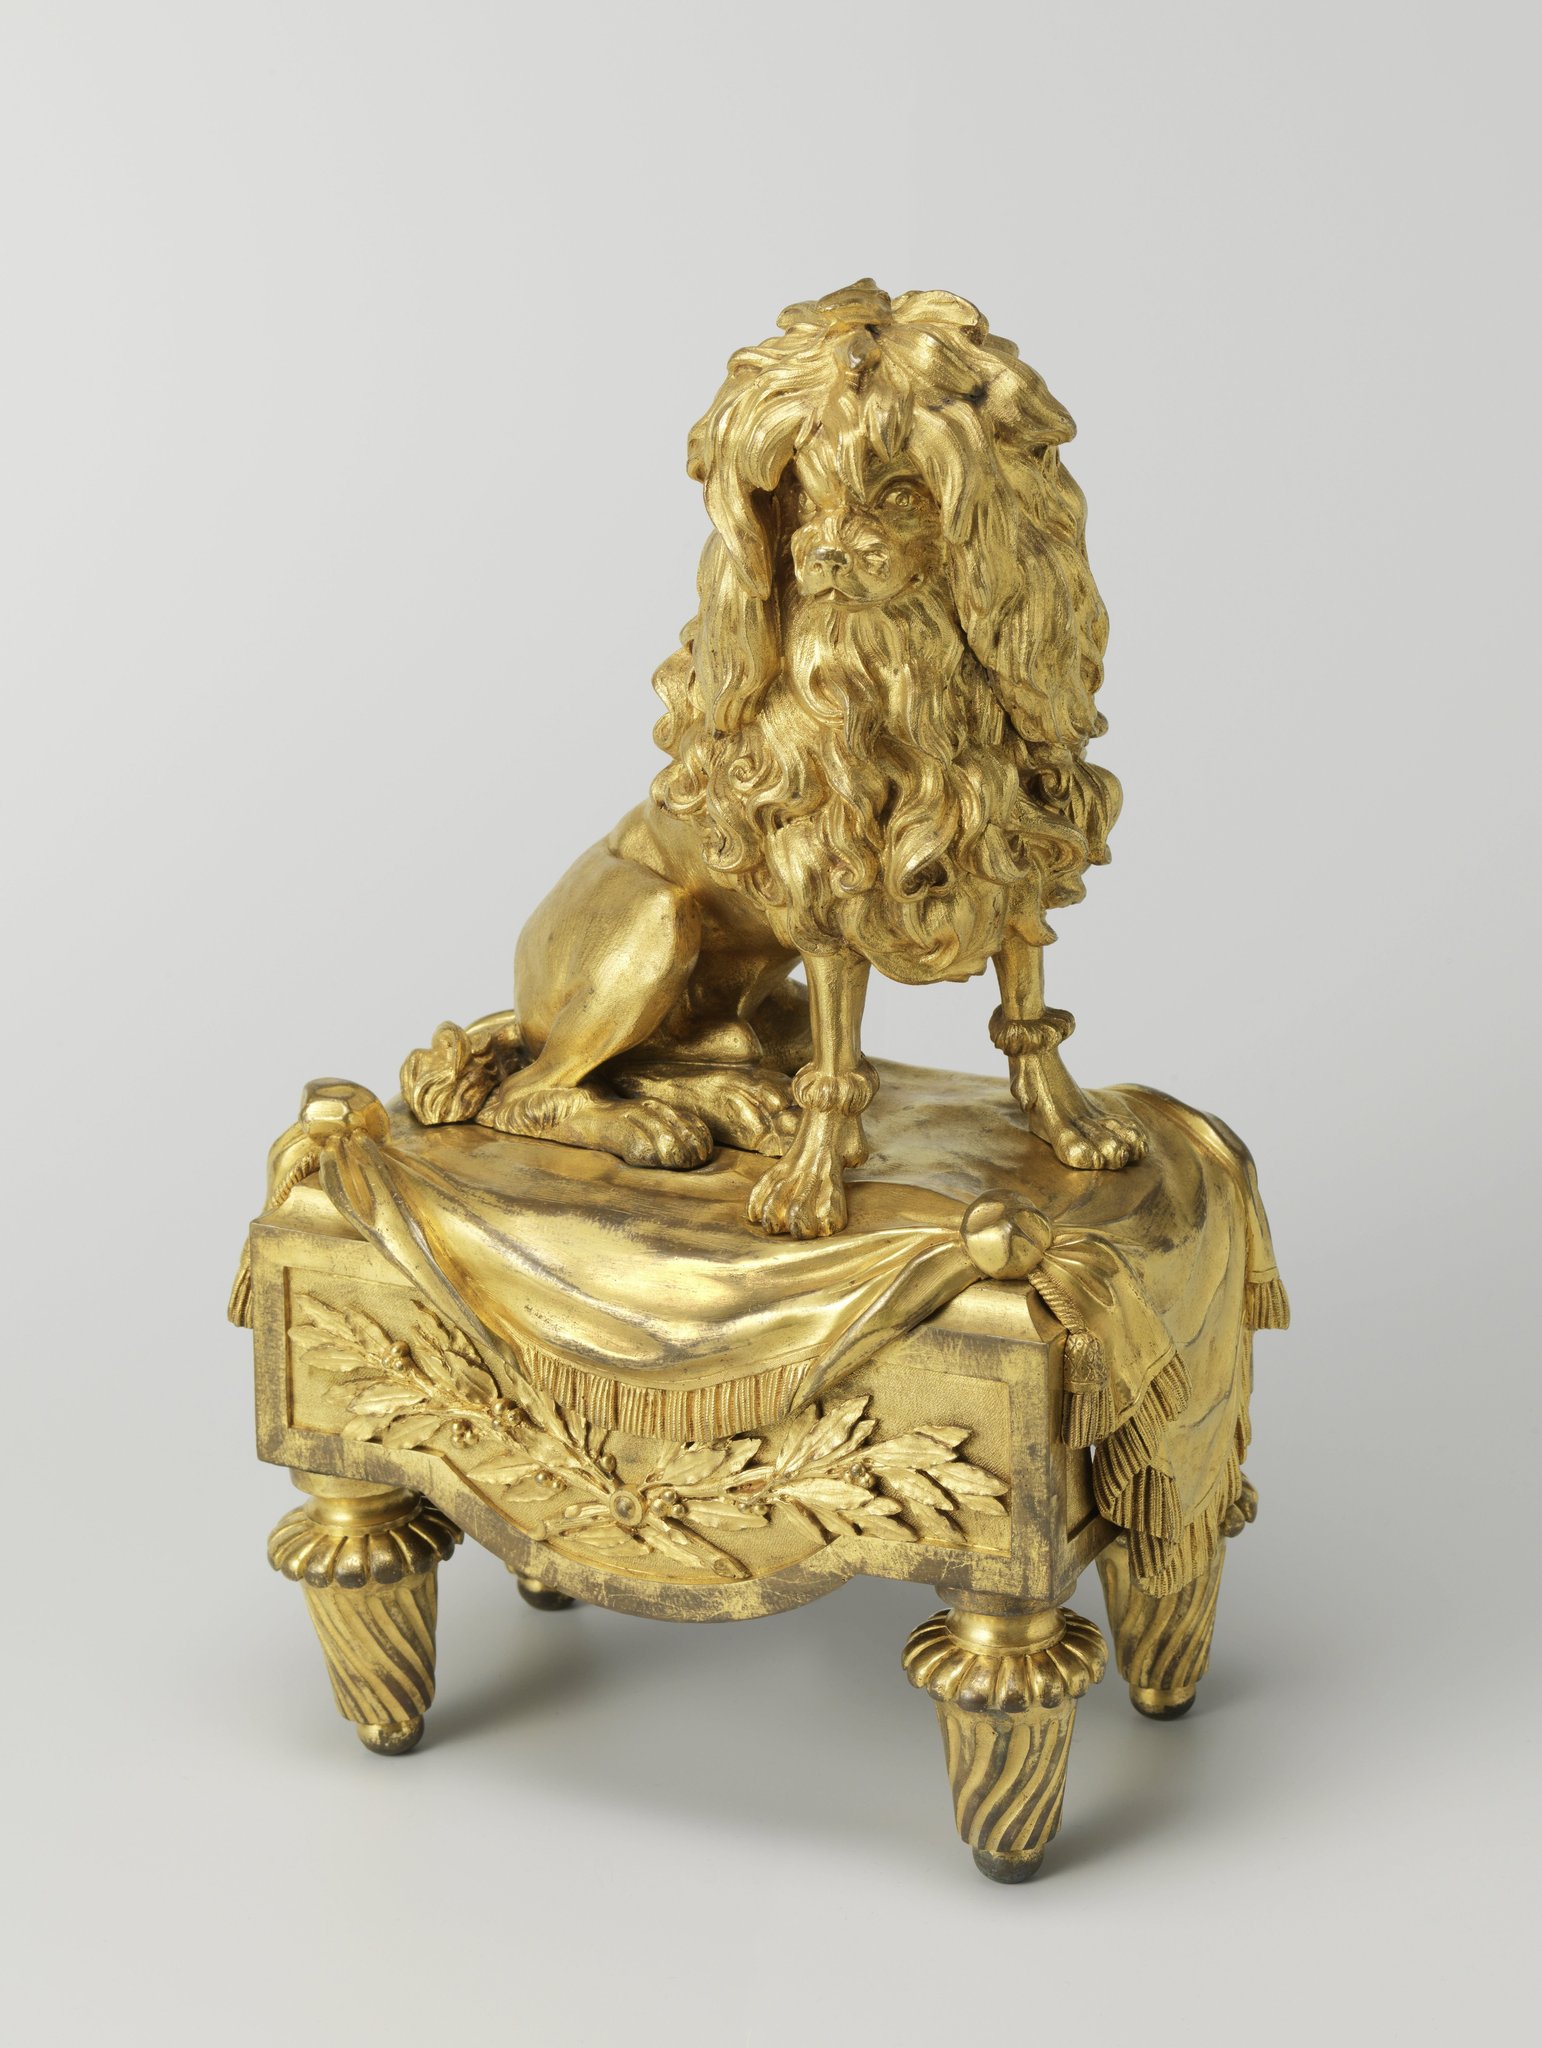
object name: andiron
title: Pair of firedogs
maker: philippe caffieri (le jeune)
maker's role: print maker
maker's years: 1714-1774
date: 1770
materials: bronze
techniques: gilding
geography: france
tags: dog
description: Firedogs were placed in the hearth as supports for the metal rods on which the logs of wood were laid. The poodle and the cat seem to be warming them-selves by the fire. The famous bronze-caster Philippe Caffieri is known to have made firedogs with such animals.